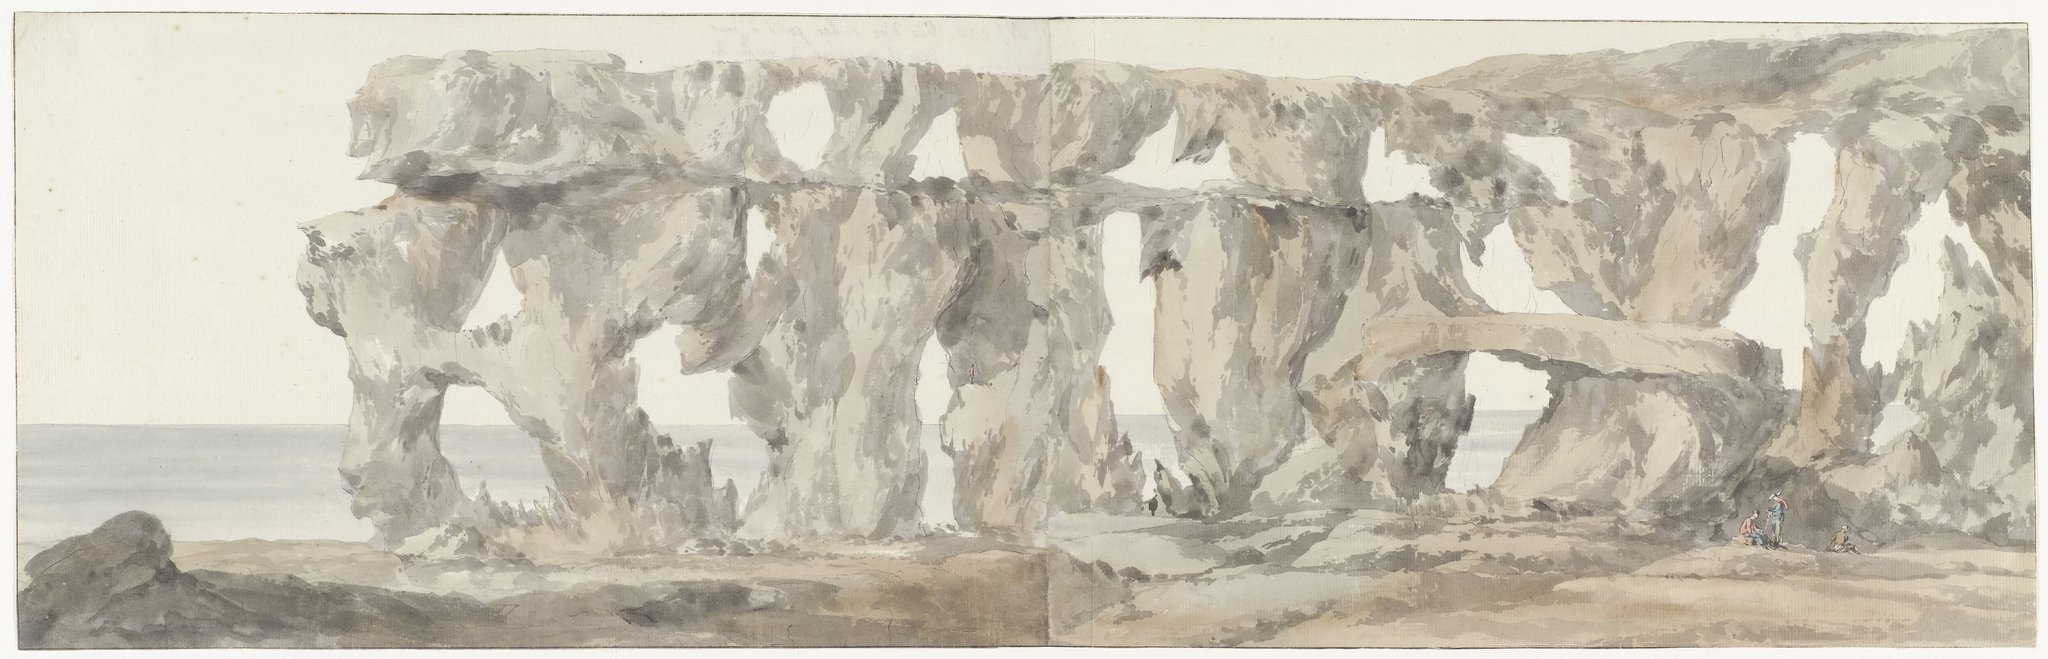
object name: watercolor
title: Gezicht op een rots onderweg bij bezichtiging van eiland Ghozo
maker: louis ducros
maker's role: draughtsman, print maker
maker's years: 1748-1810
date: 1778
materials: paper, watercolor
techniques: brush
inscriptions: inscription: ‘No 220 Vue d'une rocher percé à jour dans le voisinage de l'île de Ghozo’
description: Tekening uit het album 'Voyage en Italie, en Sicile et à Malte', 1778.